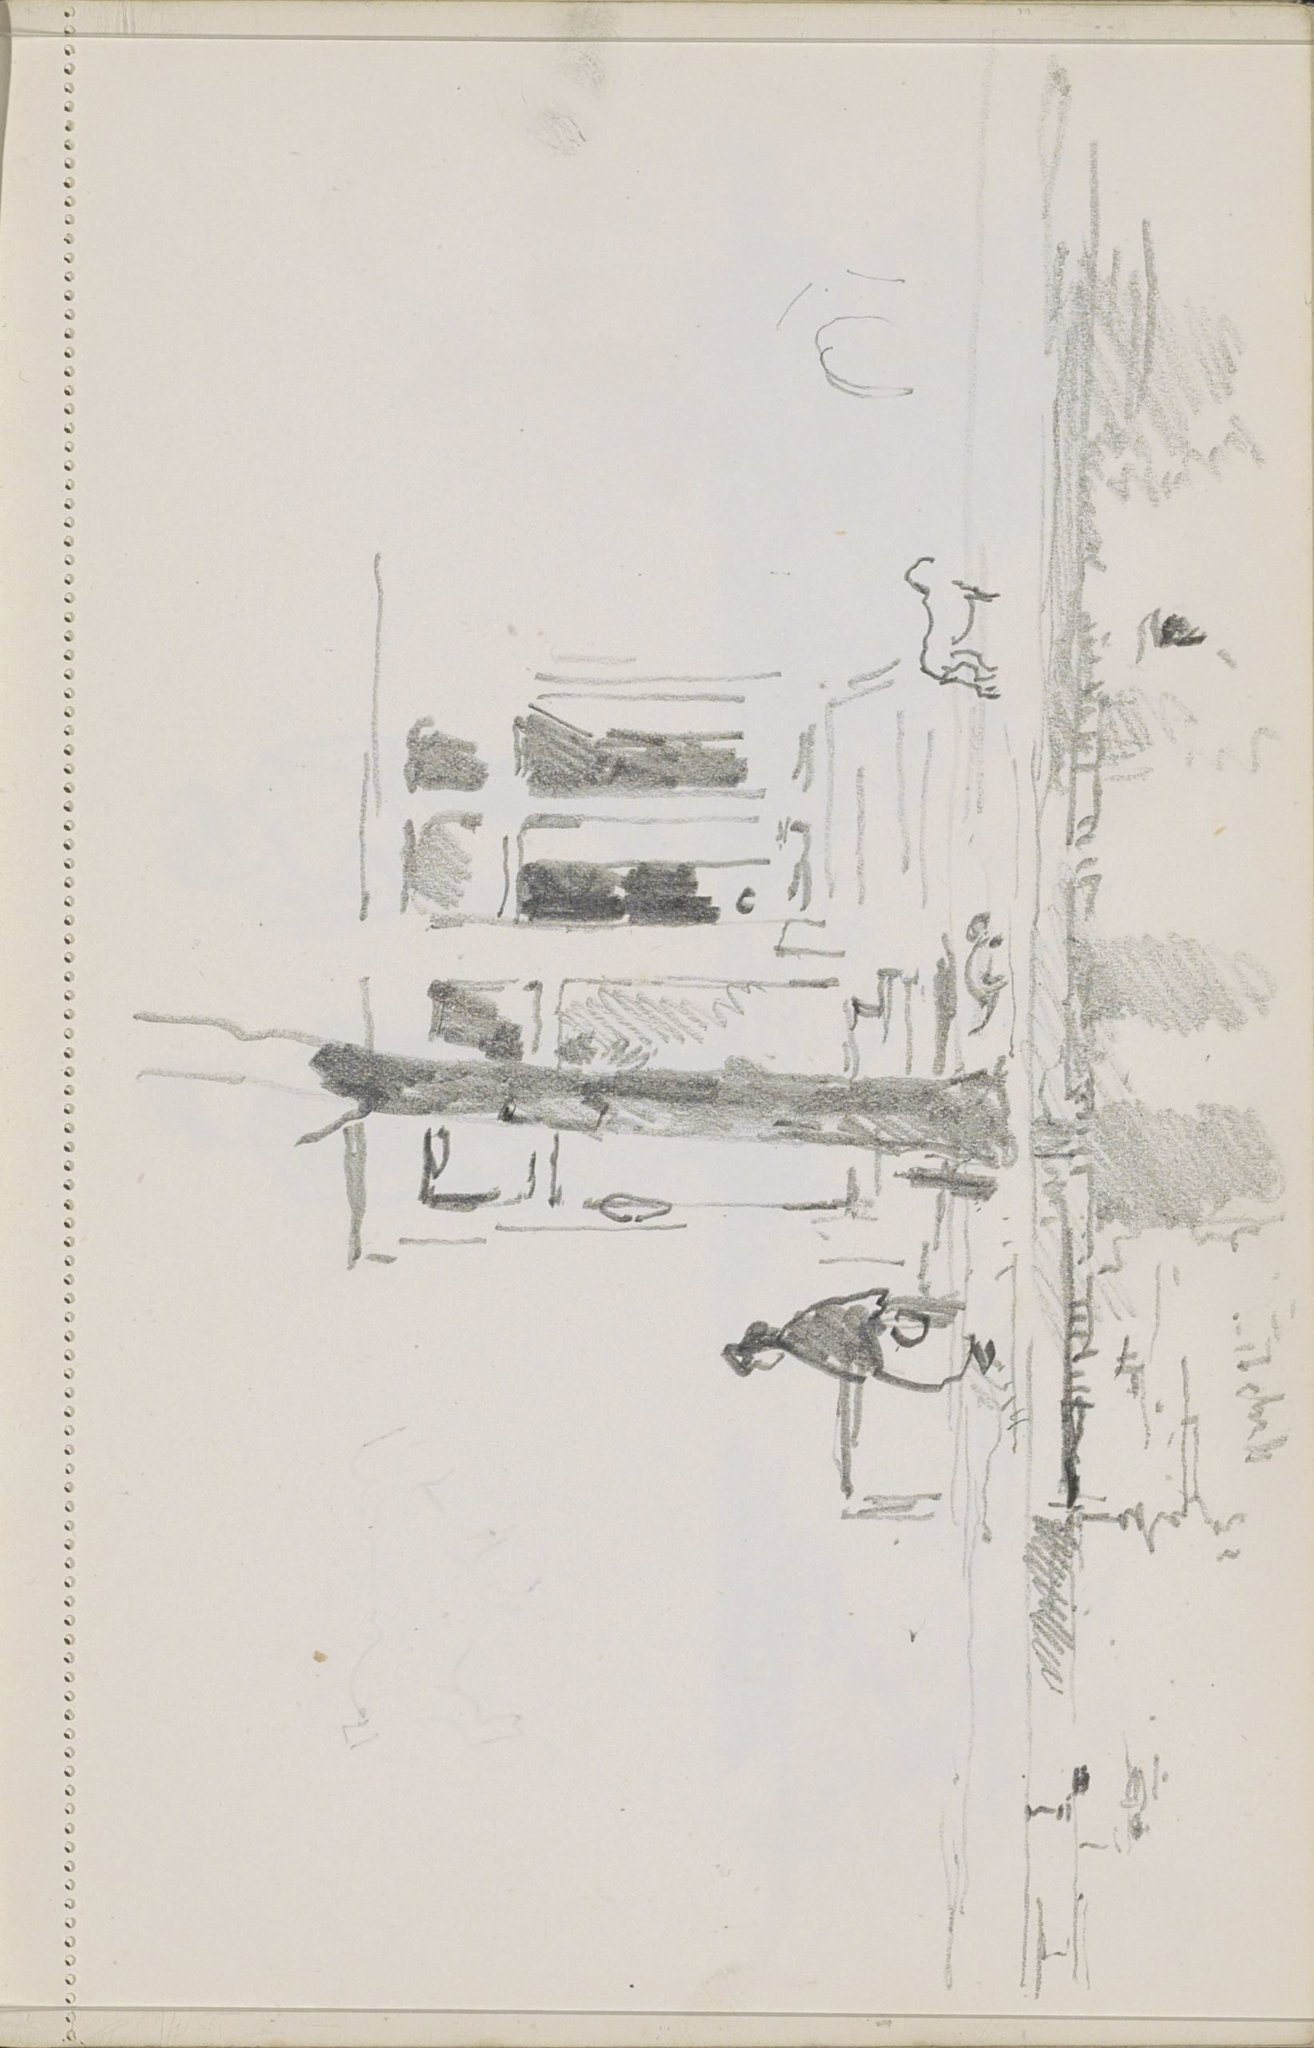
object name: sketchbook leaf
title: Vrouw lopend langs een gracht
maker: cornelis vreedenburgh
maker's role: draughtsman, print maker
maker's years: 1880-1946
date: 1890-1946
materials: paper, pencil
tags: canals, waters (in city), street (+ city(-scape) with figures, staffage)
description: Blad 20 recto uit een schetsboek met 53 bladen.